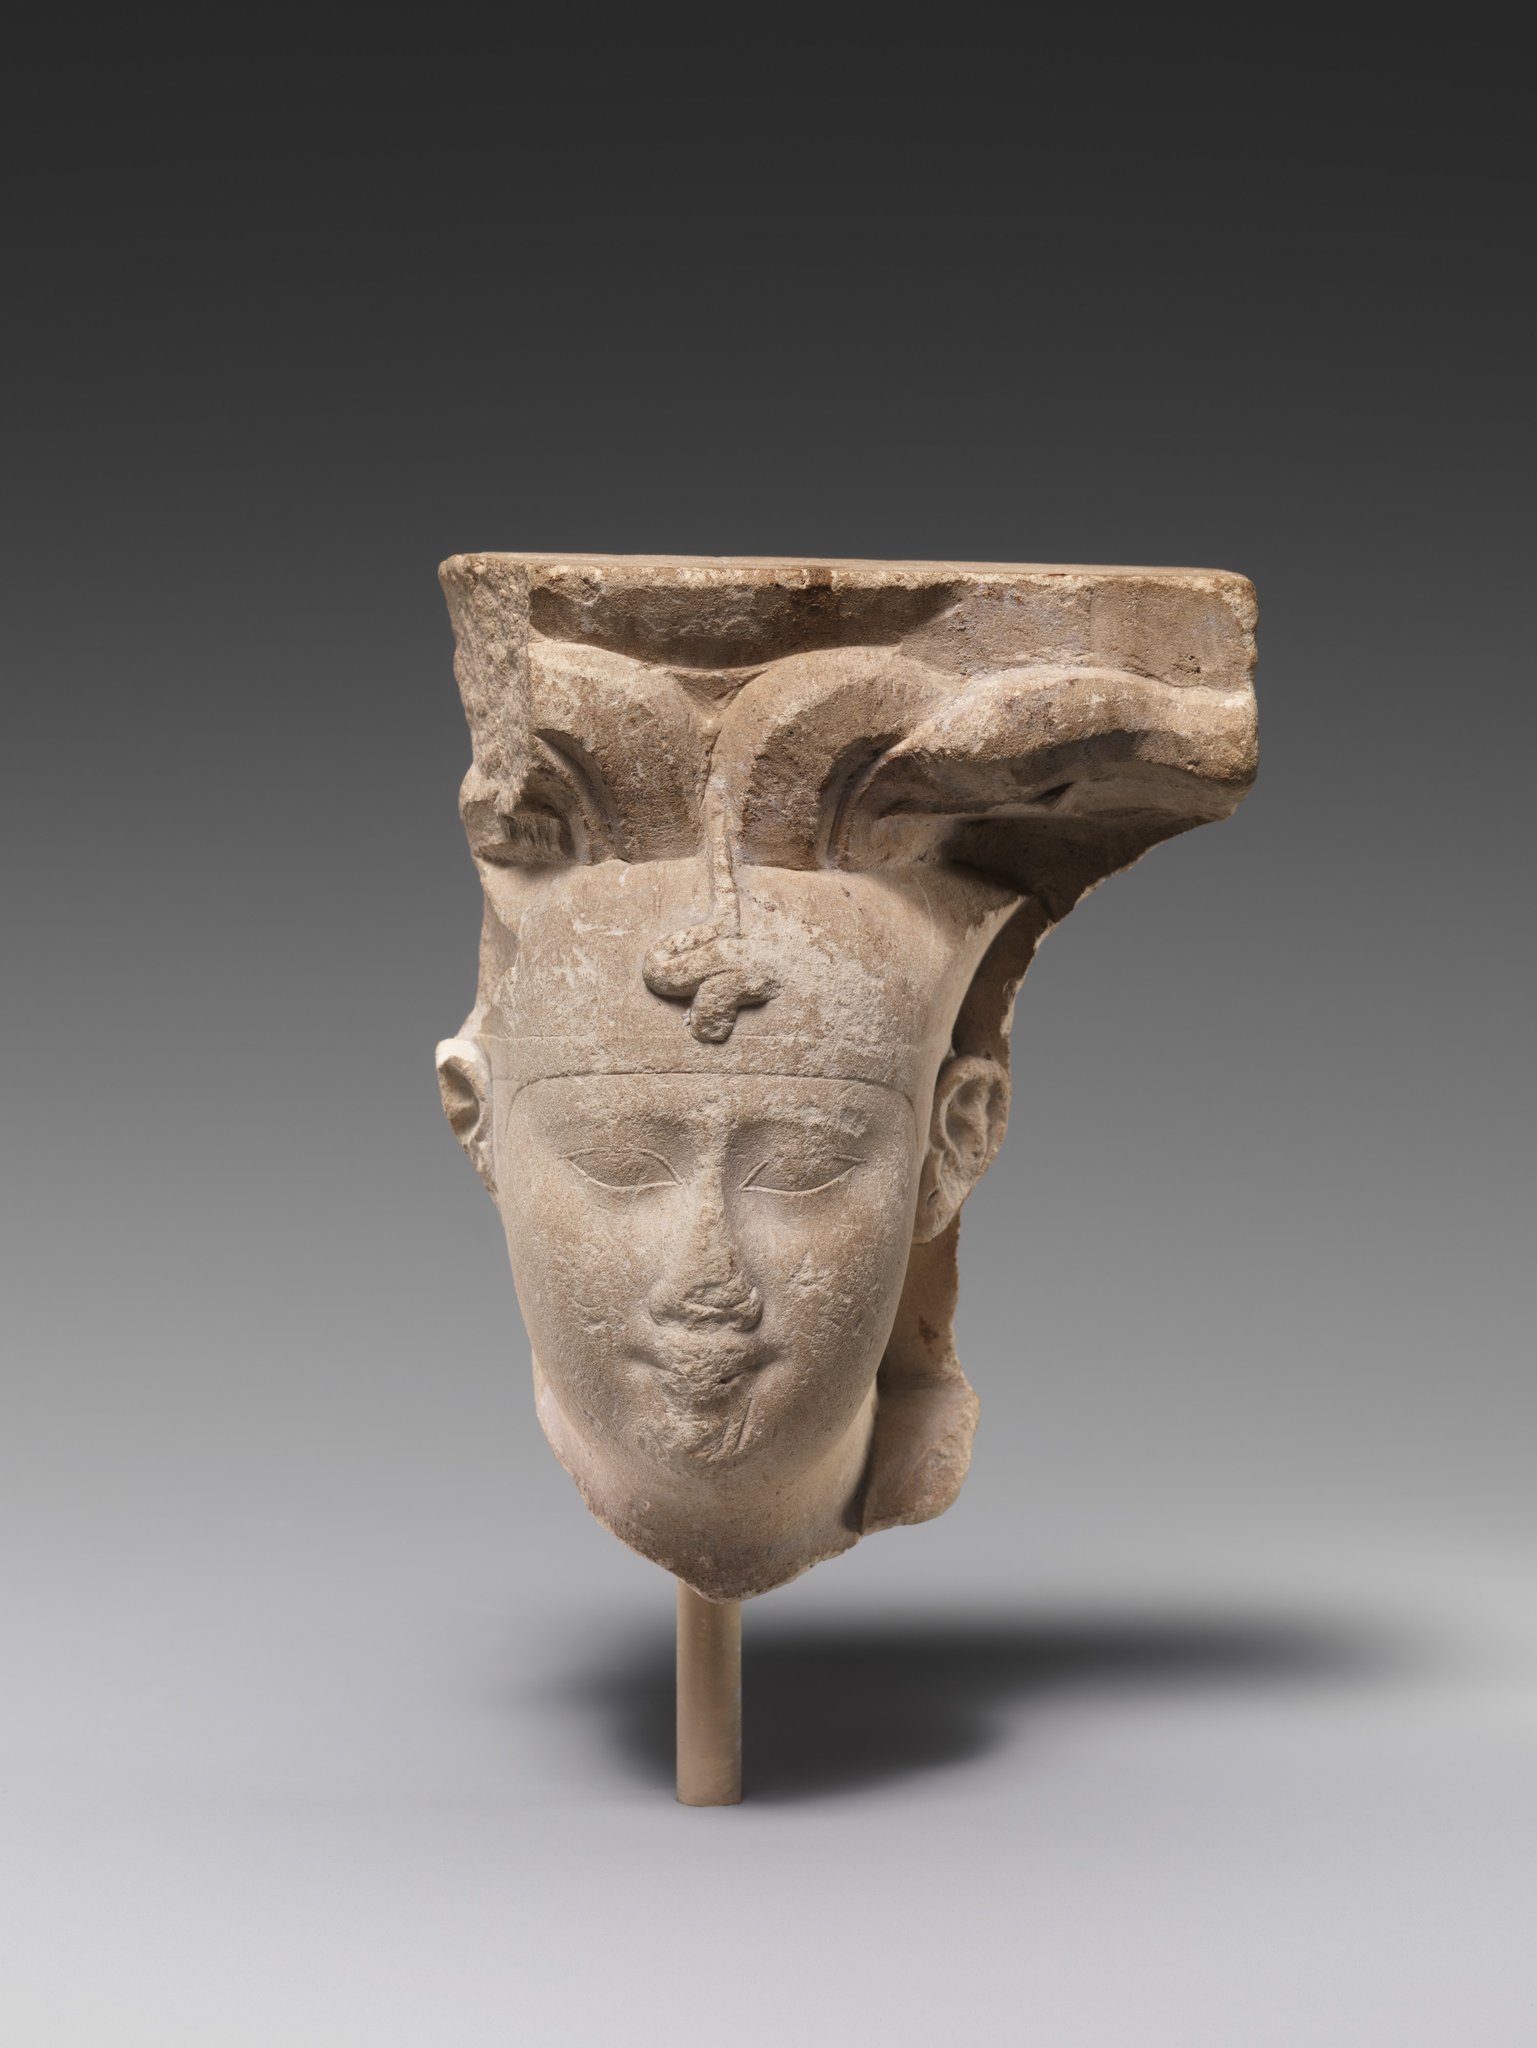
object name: sculptor's model votive, royal head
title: Royal head with an atypical snake and a headdress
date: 400-200 BCE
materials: limestone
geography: egypt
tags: human figures,heads,snakes